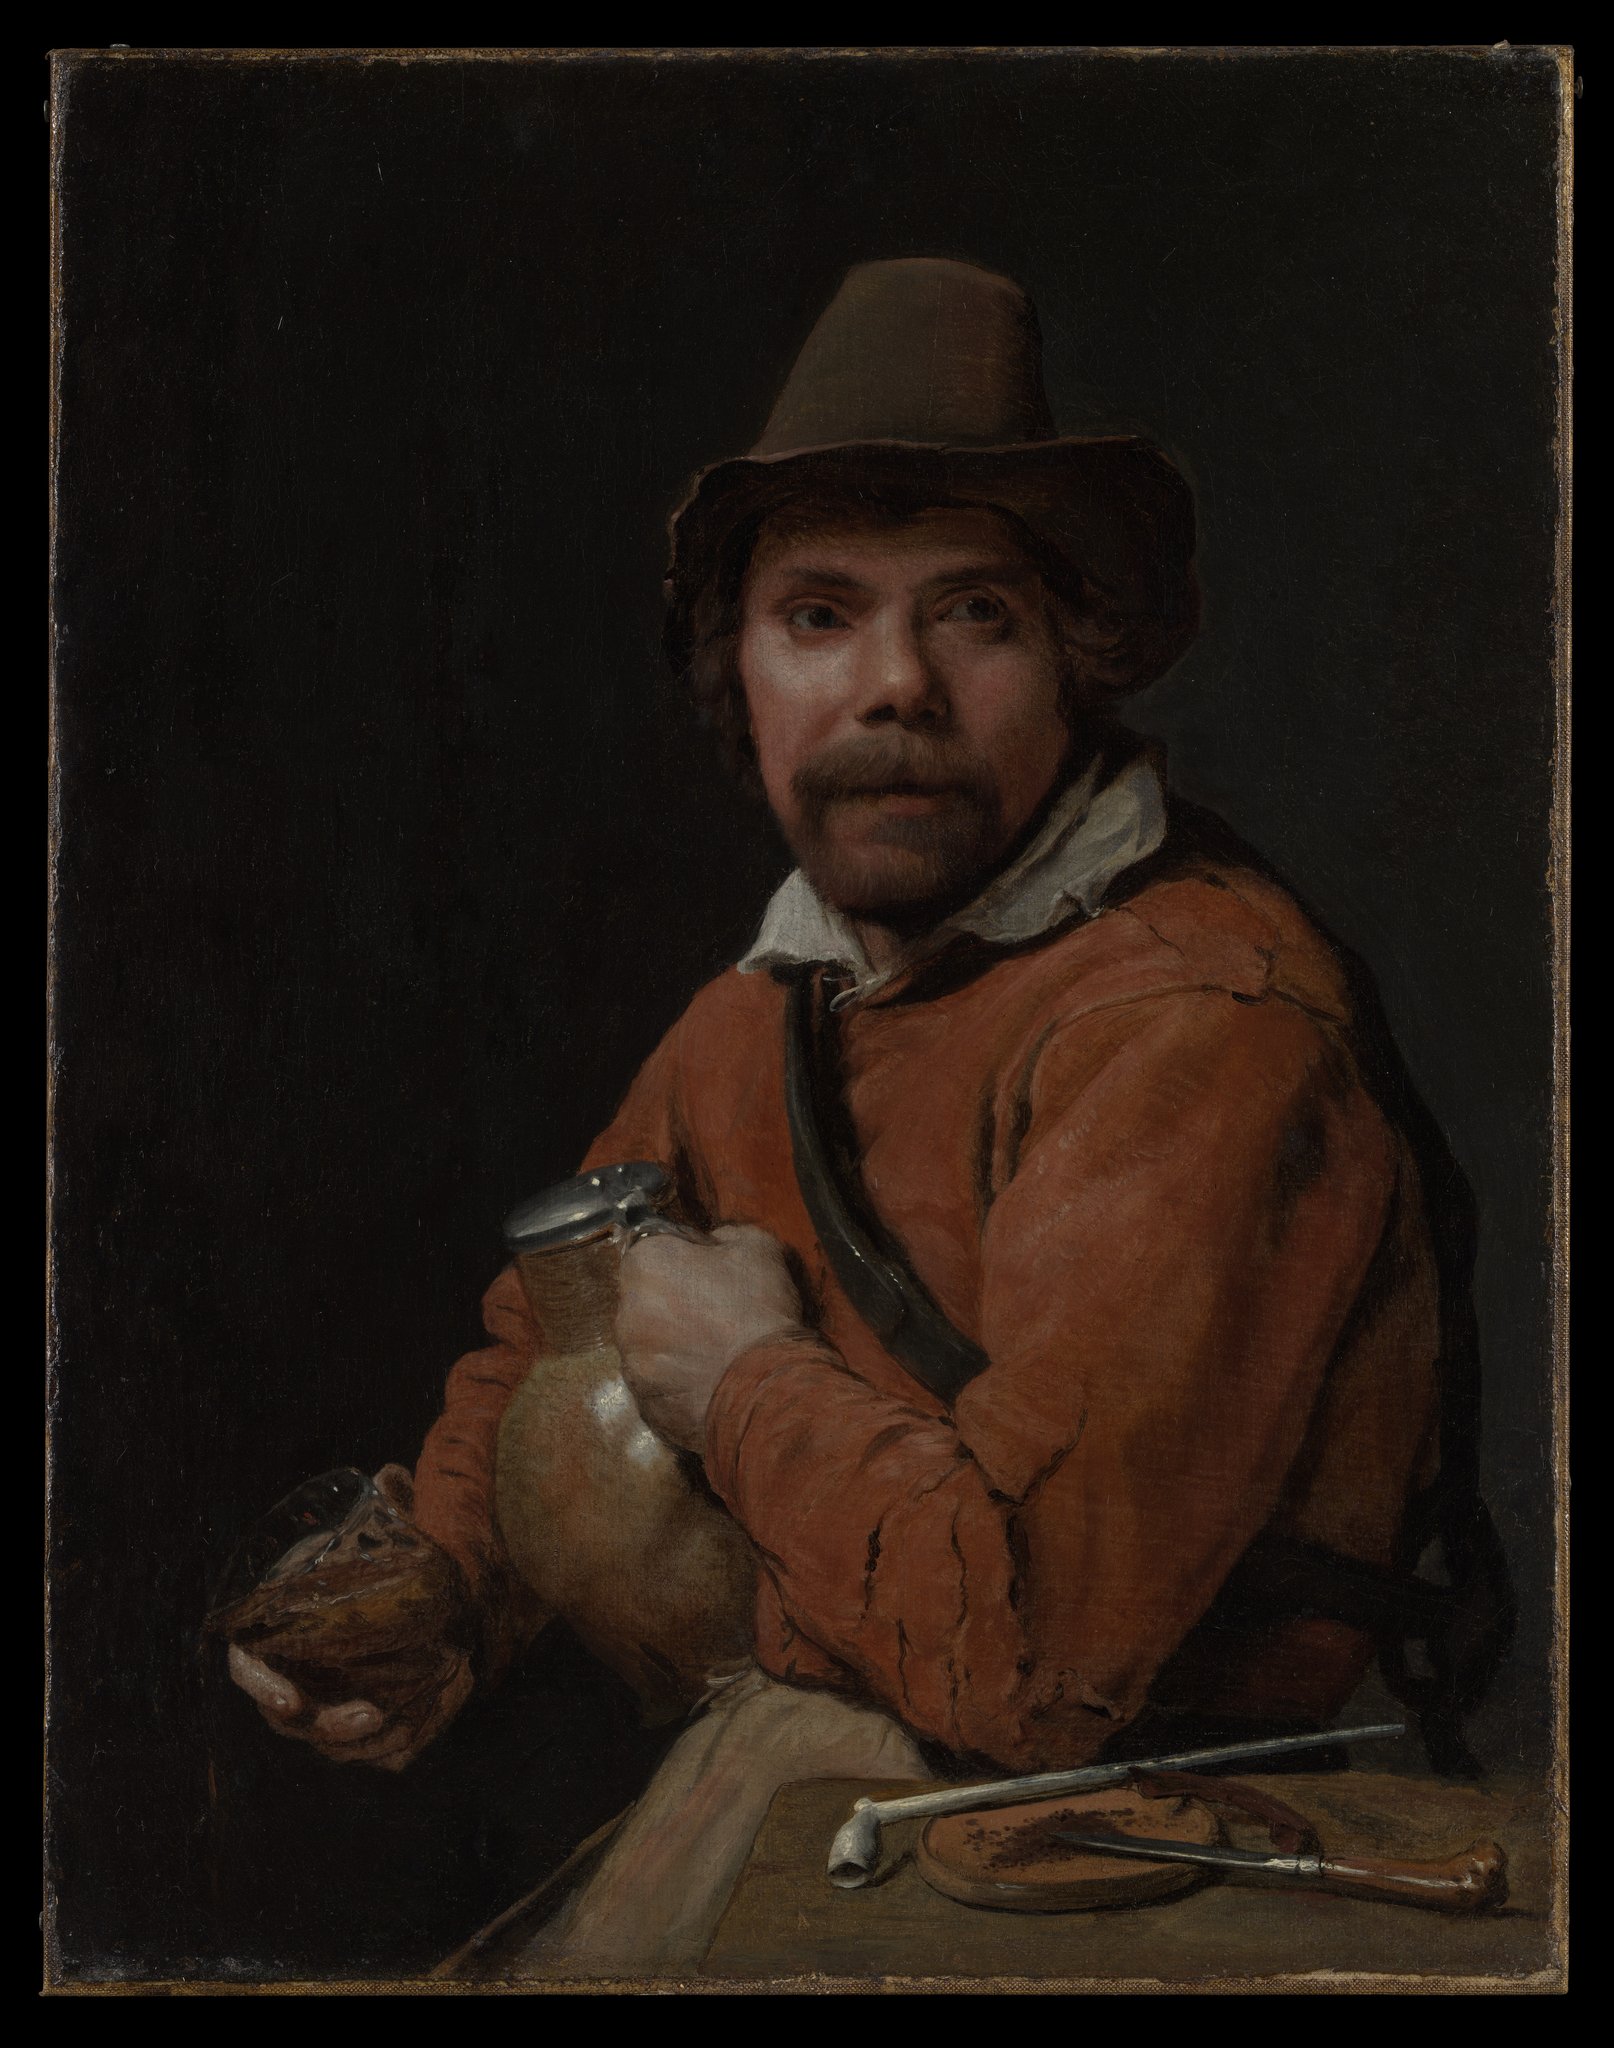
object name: painting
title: Man Holding a Jug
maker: michiel sweerts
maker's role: artist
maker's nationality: flemish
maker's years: 1618-1664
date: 1660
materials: canvas, oil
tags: men,portraits,jugs,pipes